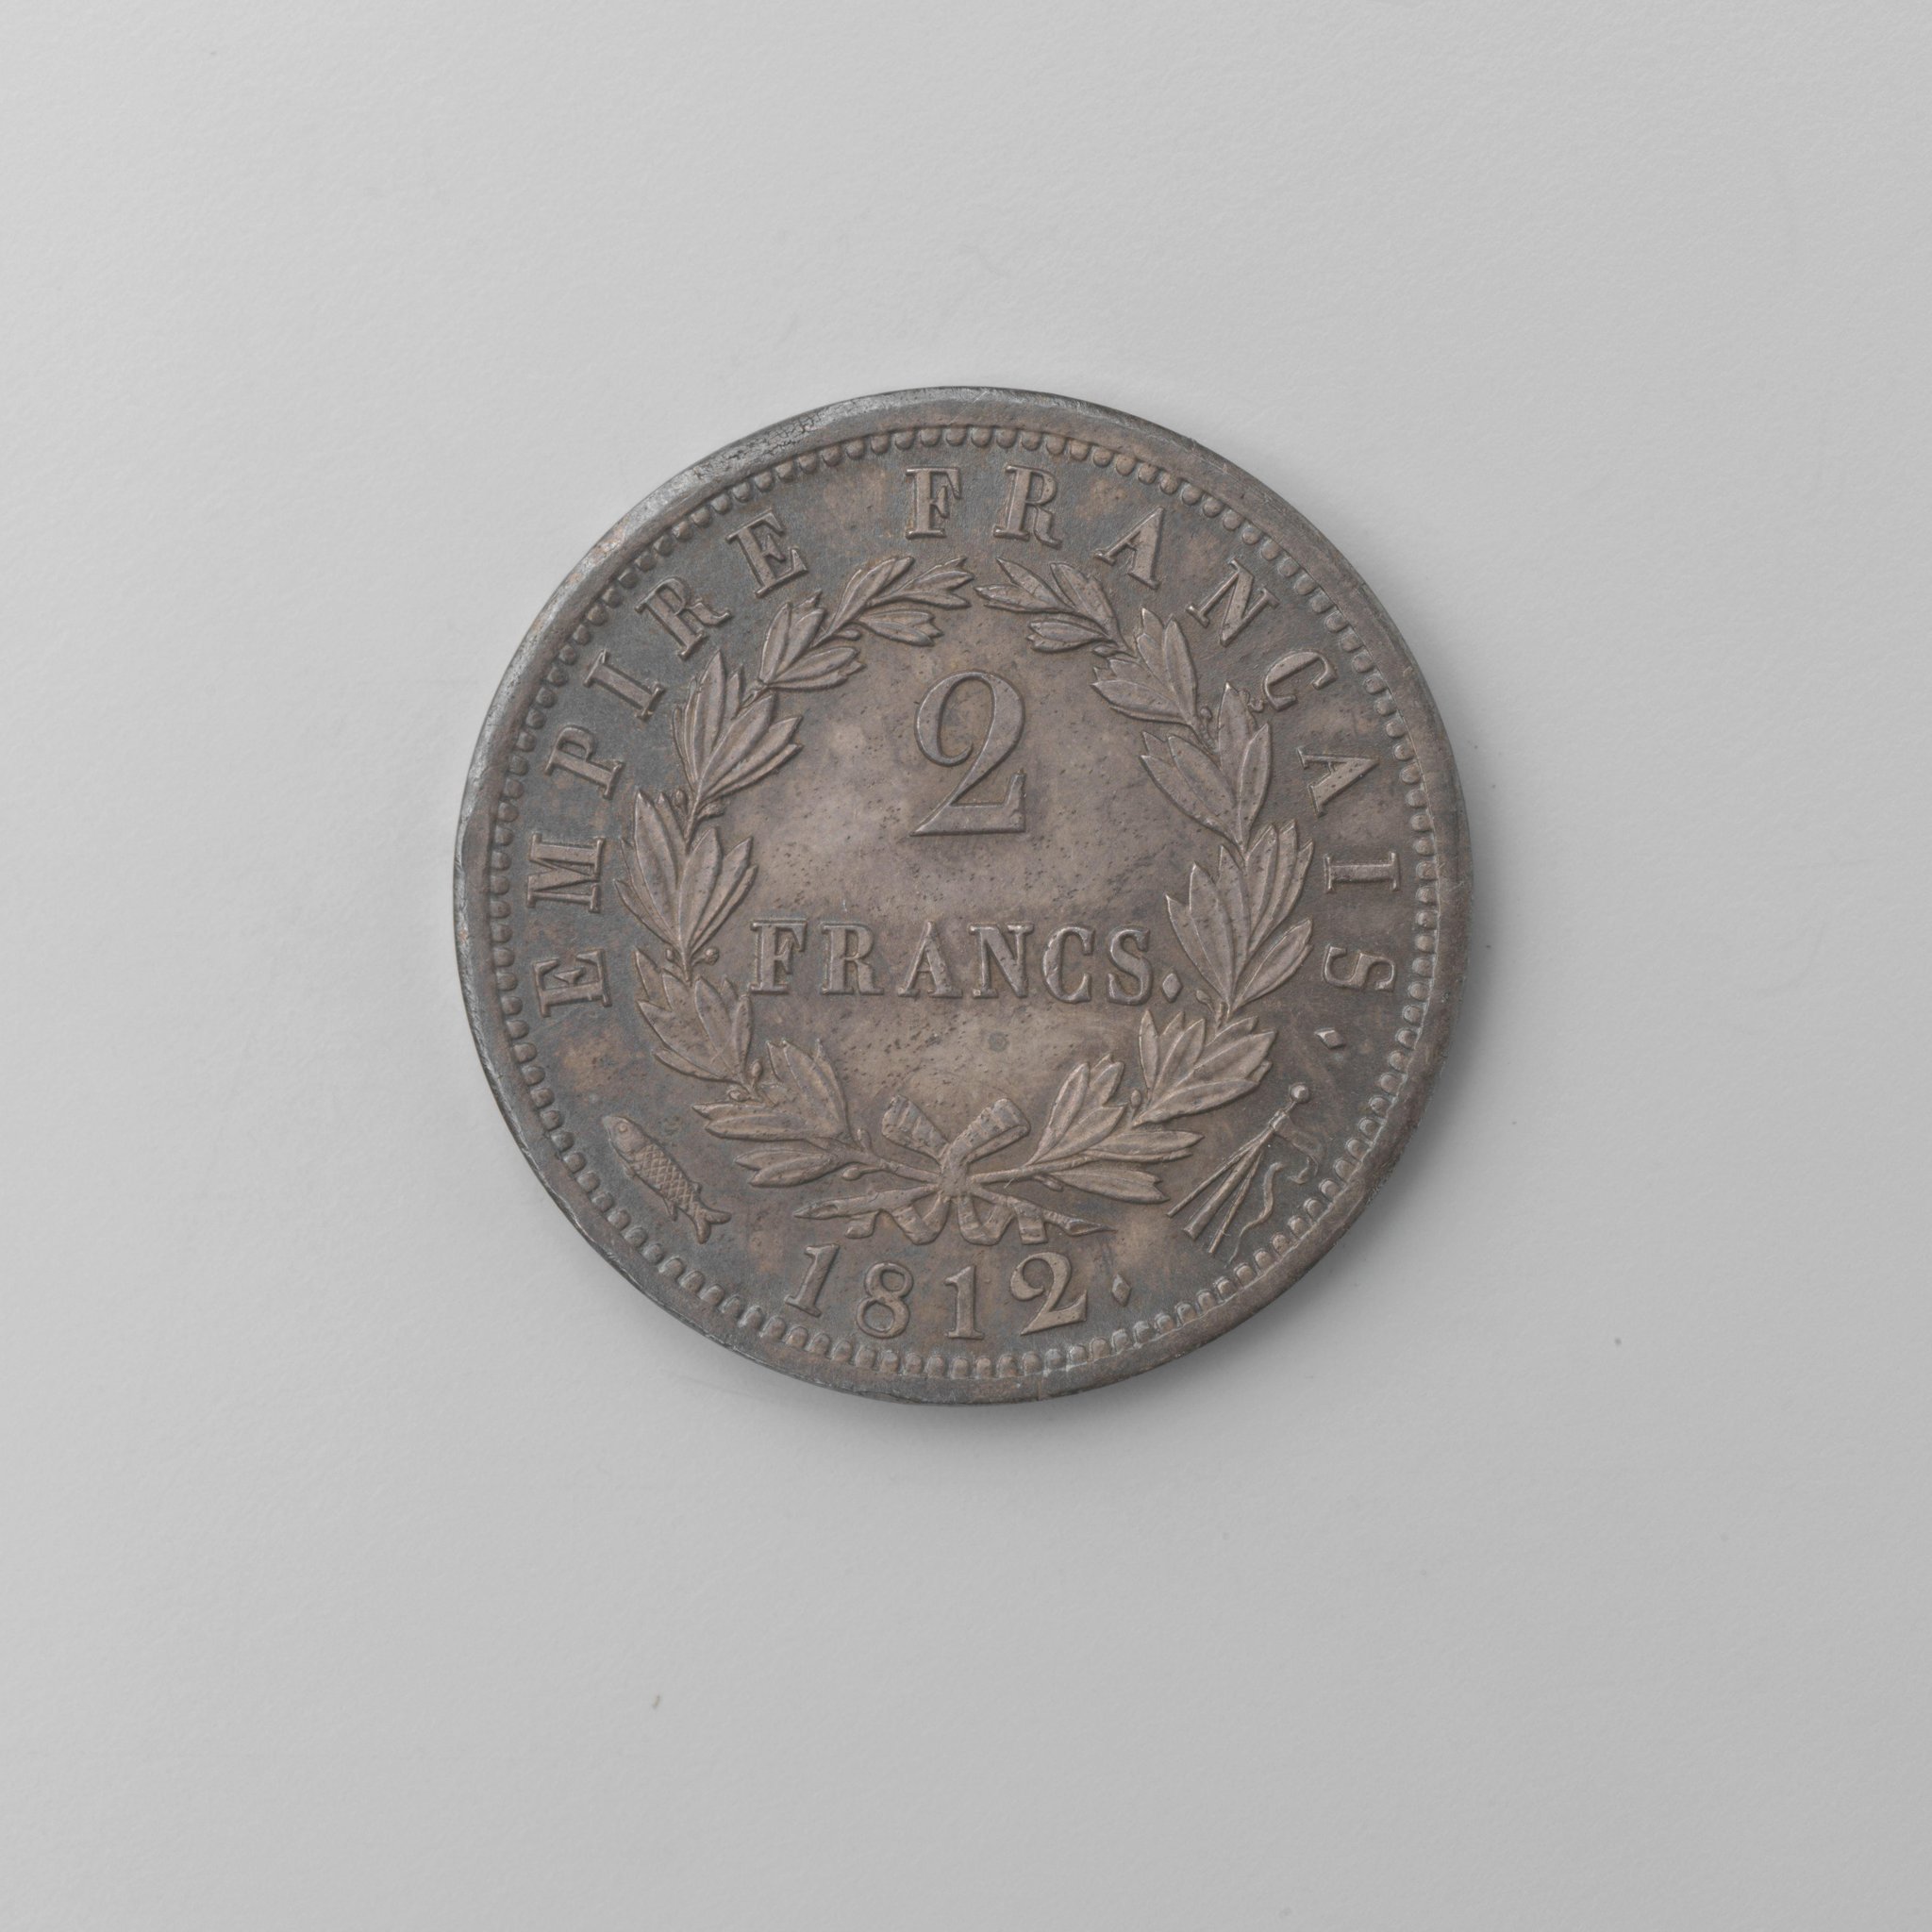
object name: coin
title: Nederlandse 2 francs, 1812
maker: napoleon i (emperor of the french)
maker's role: generaal, keizer, staatsman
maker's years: 1769-1821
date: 1812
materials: silver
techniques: striking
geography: utrecht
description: Zilveren munt. Voorzijde: gelauwerd borstbeeld van Napoleon I naar rechts. Keerzijde: binnen olijfkrans waarde-aanduiding 2 francs. Jaartal in omschrift onderaan. Randschrift.